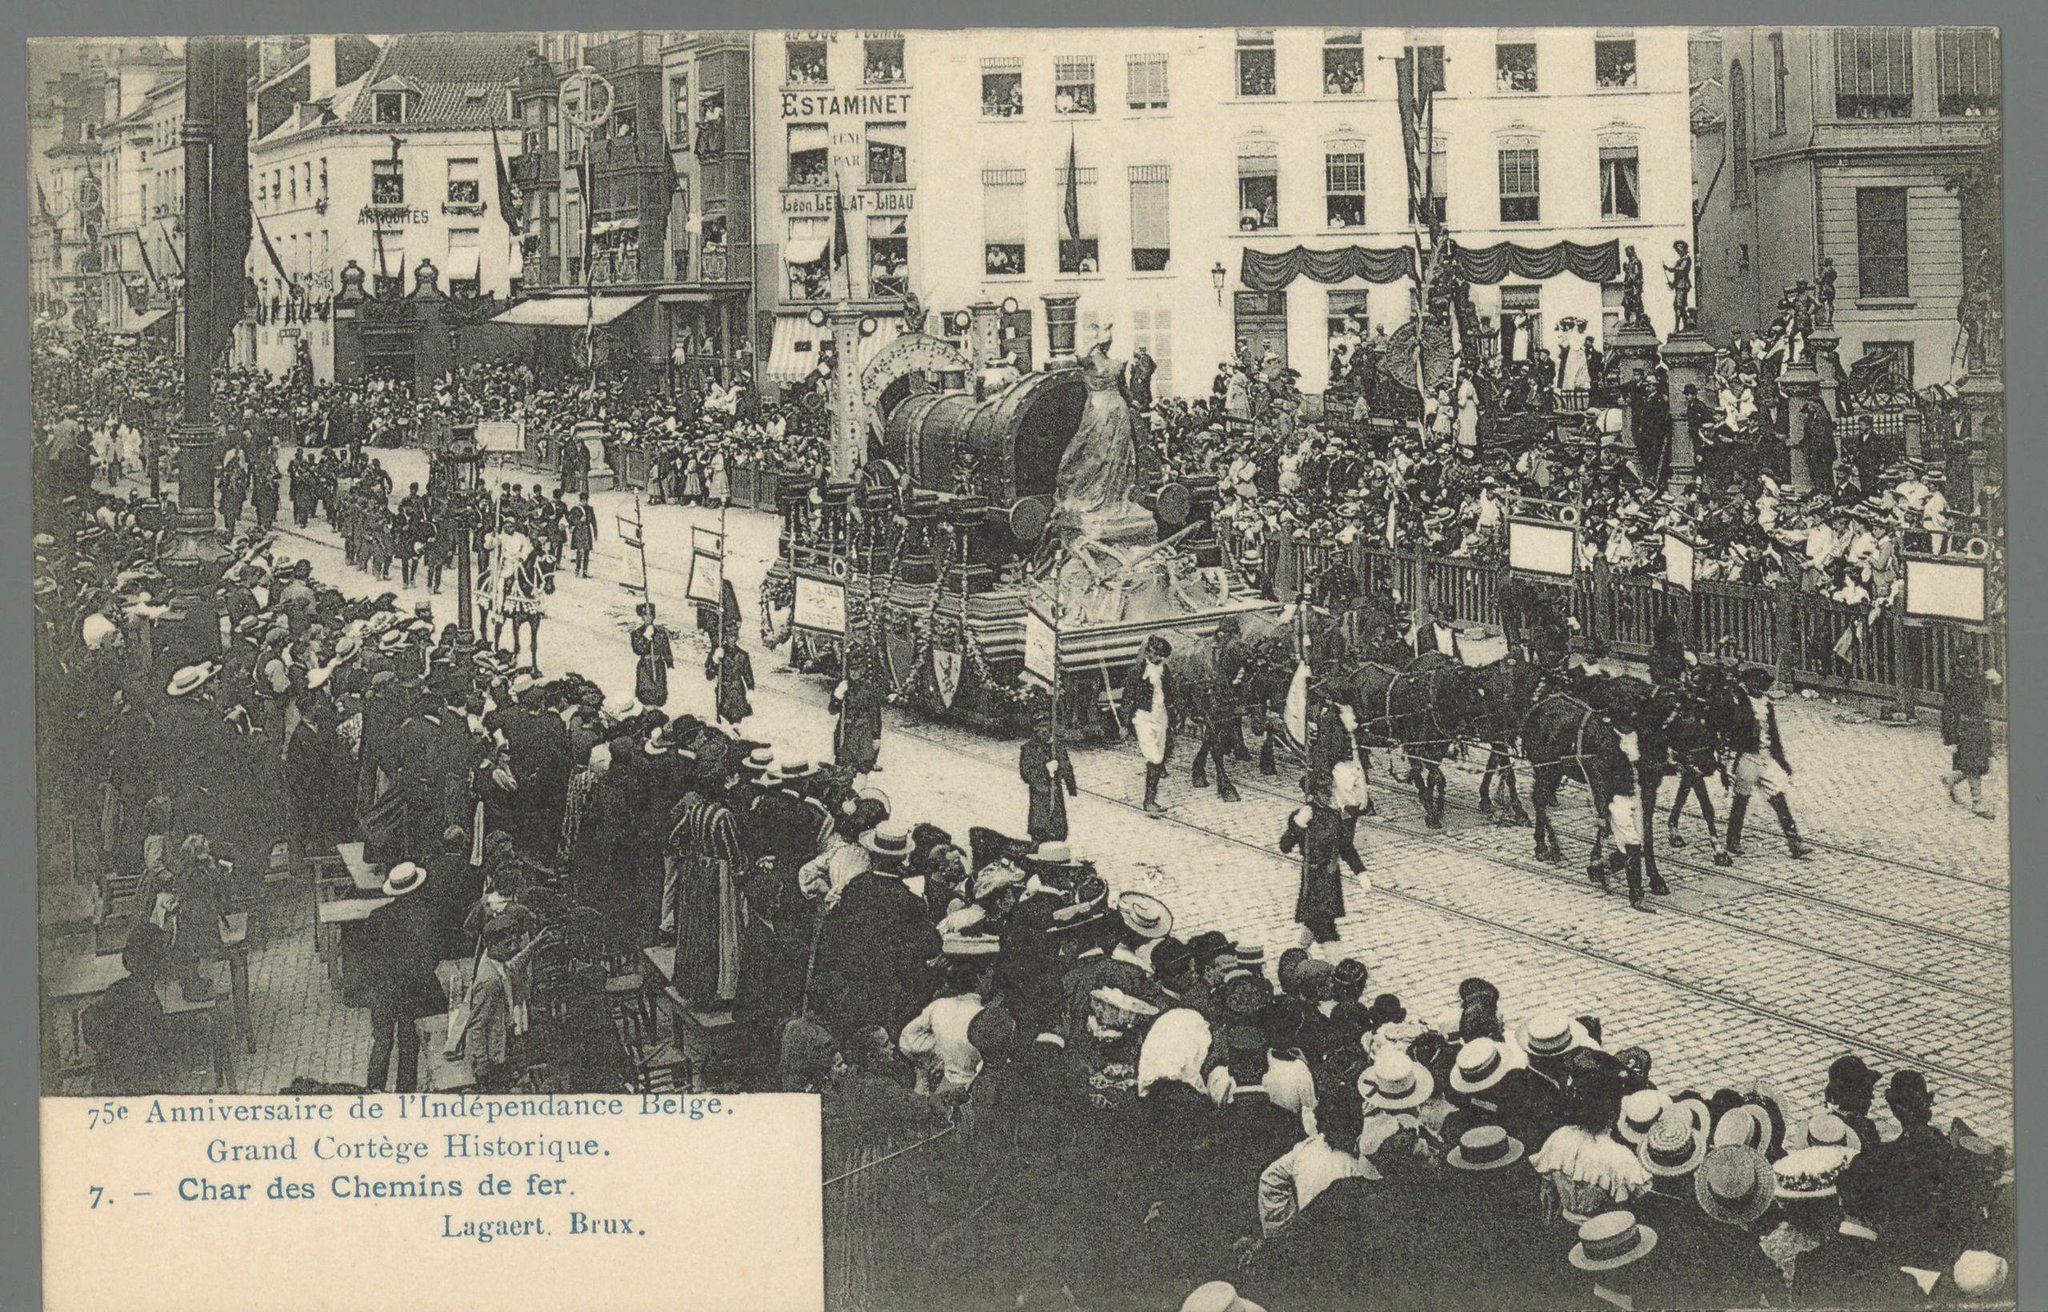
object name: photomechanical print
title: Char des Chemins de fer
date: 1905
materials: cardboard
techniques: photograph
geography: brussels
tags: city-view, and landscape with man-made constructions (+ city(-scape) with figures, staffage), periodic celebrations, popular feasts, brussels